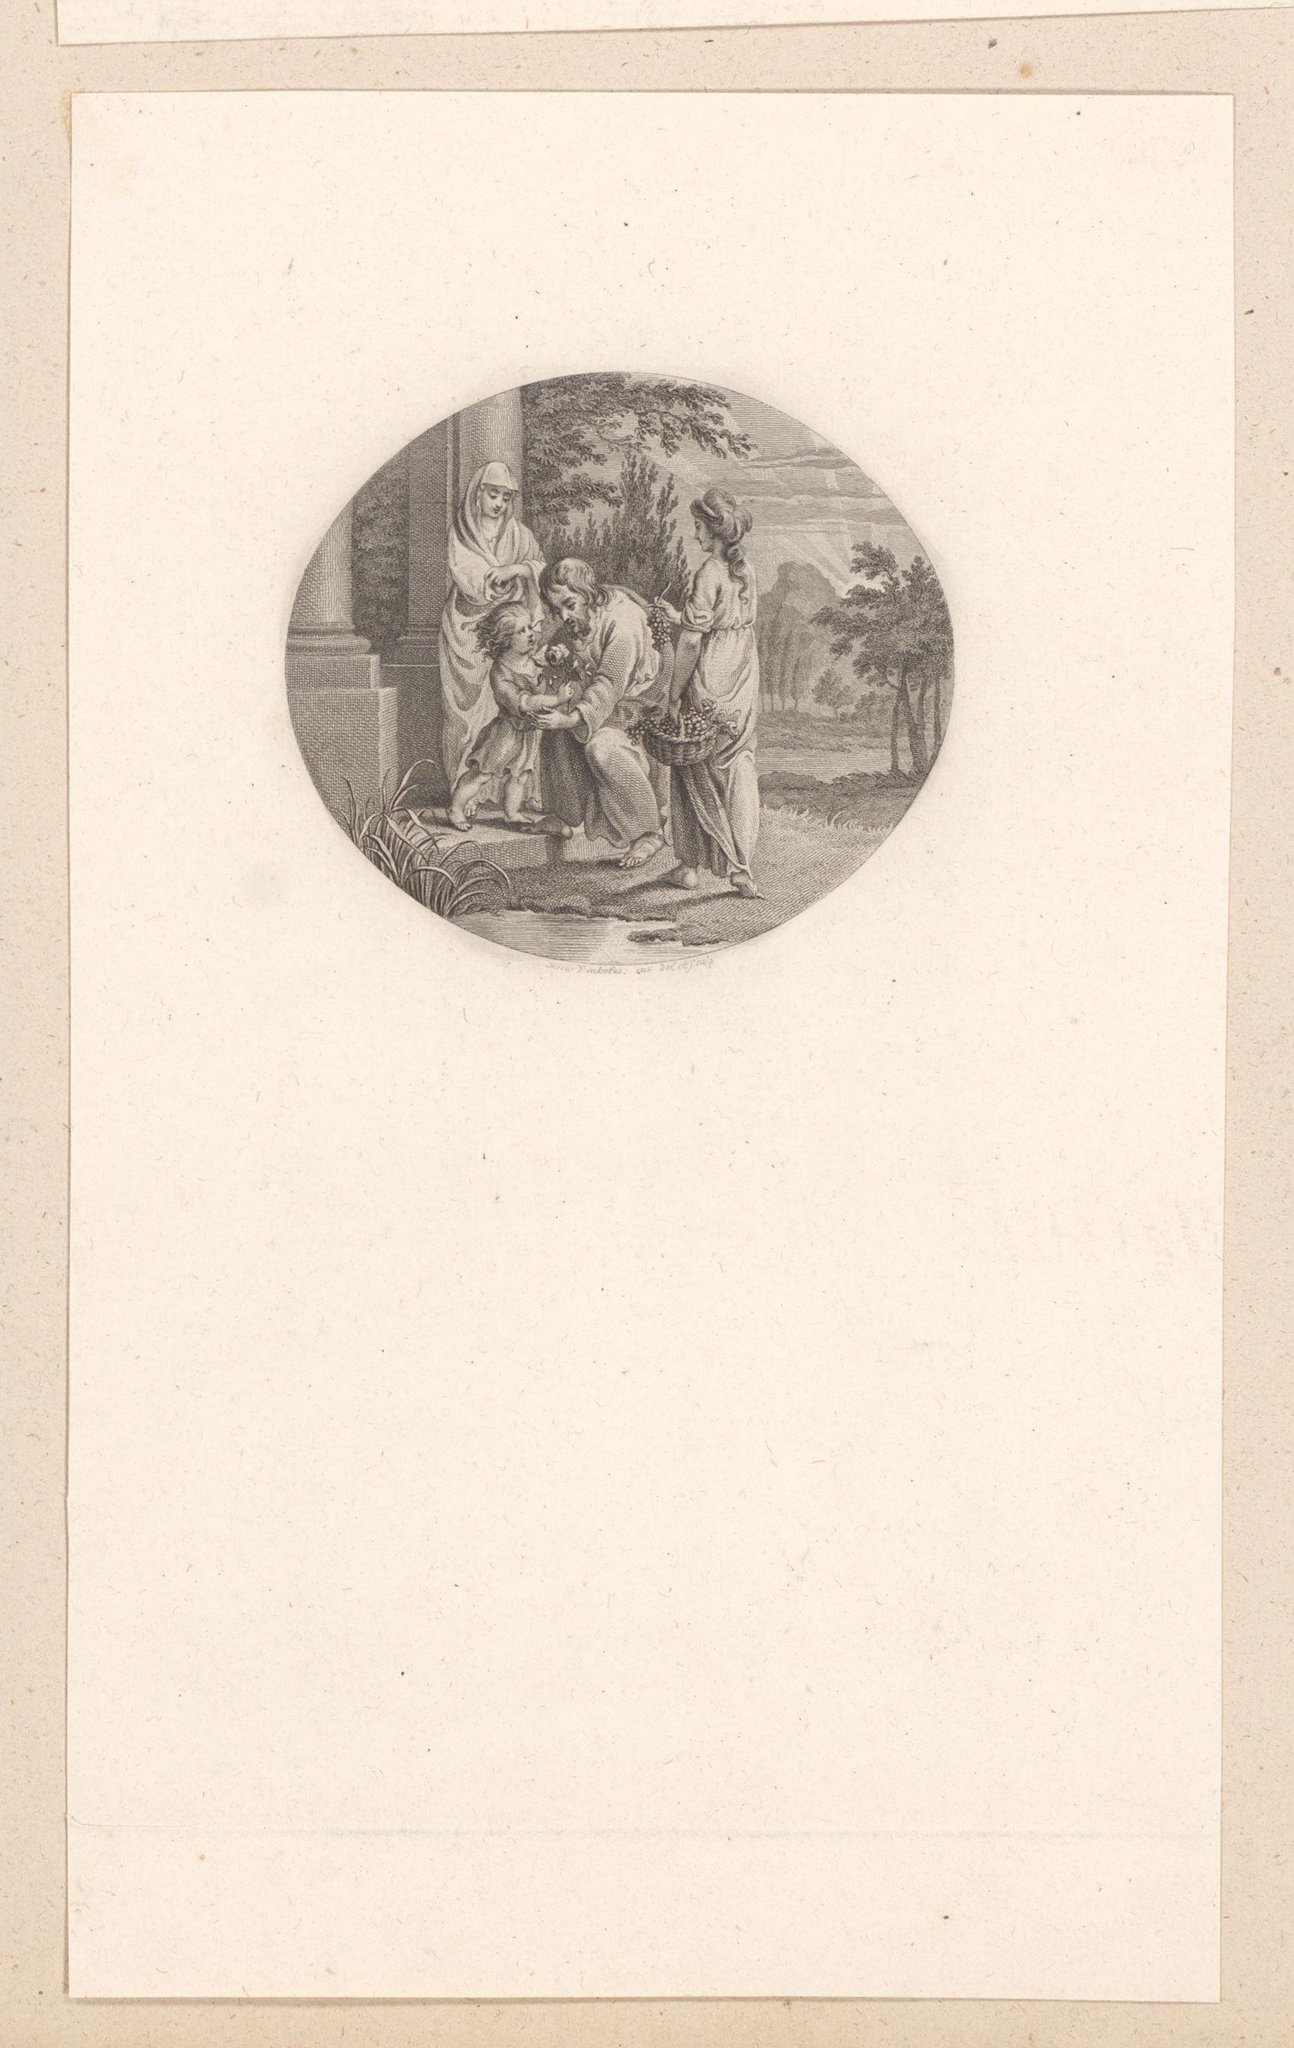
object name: album leaf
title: Lazarus krijgt van de zoon van zijn tuinman een roos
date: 1795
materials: paper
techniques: etching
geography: amsterdam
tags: the story of lazarus (john 11:1-44)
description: Tijdens een avondwandeling met zijn zusters krijgt Lazarus van de zoon van zijn tuinman een roos. Als hij er aan ruikt, krijgt hij koorts en sterft. De prent maakt deel uit van een album.